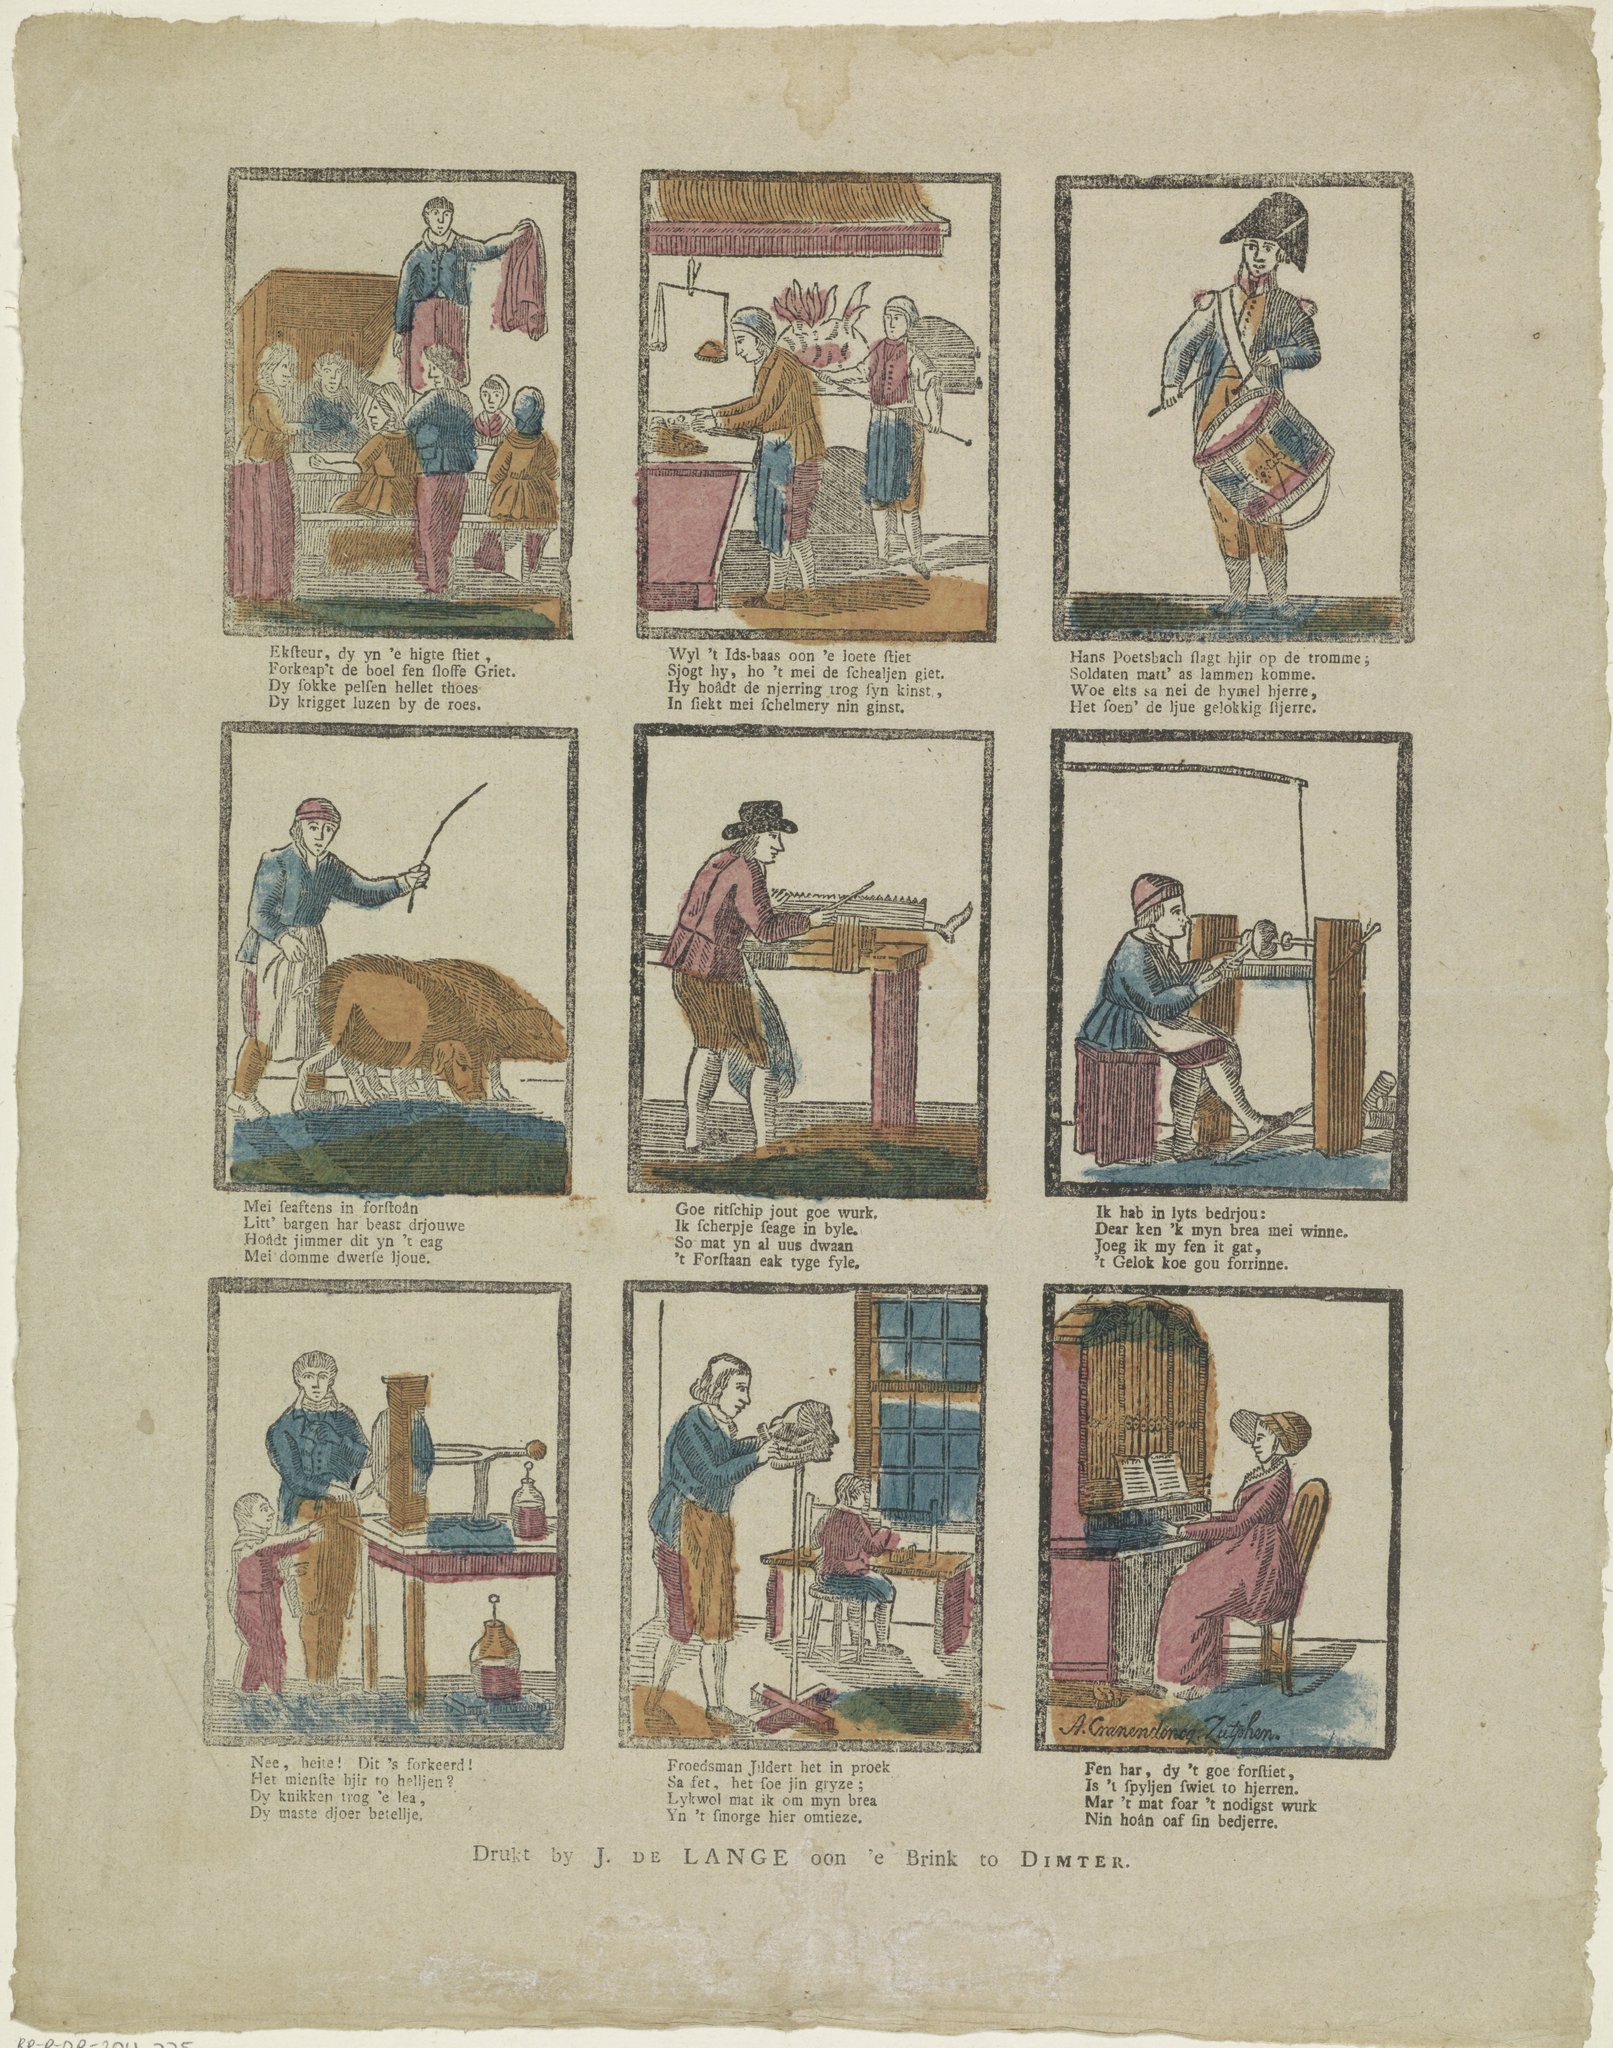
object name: popular print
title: Beroepen en ambachten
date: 1822-1849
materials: paper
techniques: colour, letterpress printing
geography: deventer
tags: wigmaker, 'perruquier', craft-production, skilled handiwork, farmers, working class, labourers, street-trader, crafts and industries, merchant, salesman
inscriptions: collector's mark: Lugt 2760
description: Blad met 9 voorstellingen van ambachtslieden en beroepen, zoals straatverkoper, tamboer, timmerman en pruikenmaker. Onder elke afbeelding een vierregelig vers in het Fries.